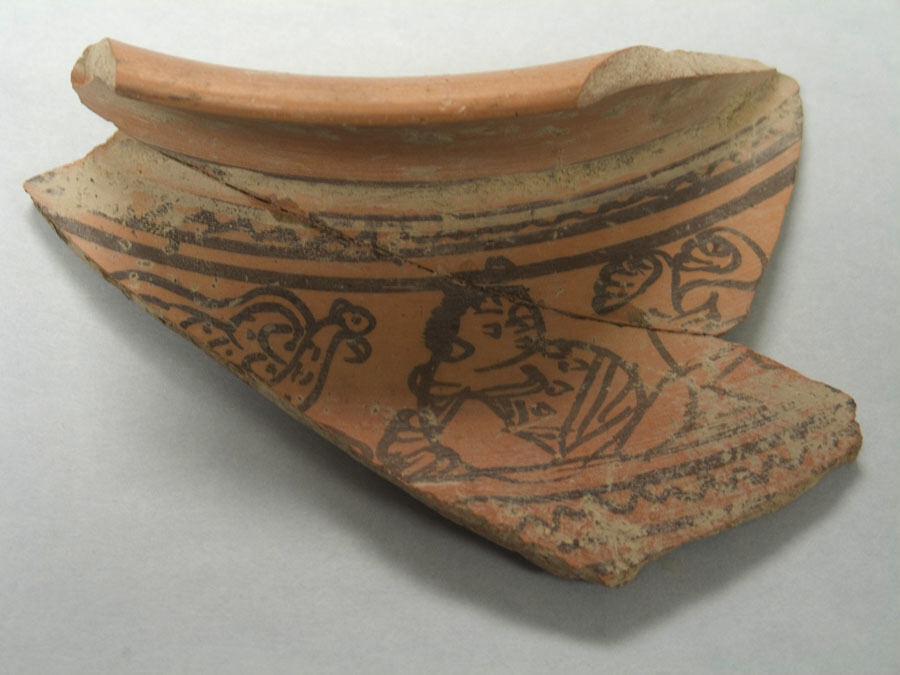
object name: shard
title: Repaired Shard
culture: pakistani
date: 301-500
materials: terracotta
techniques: painting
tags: human figures,birds,gandhara